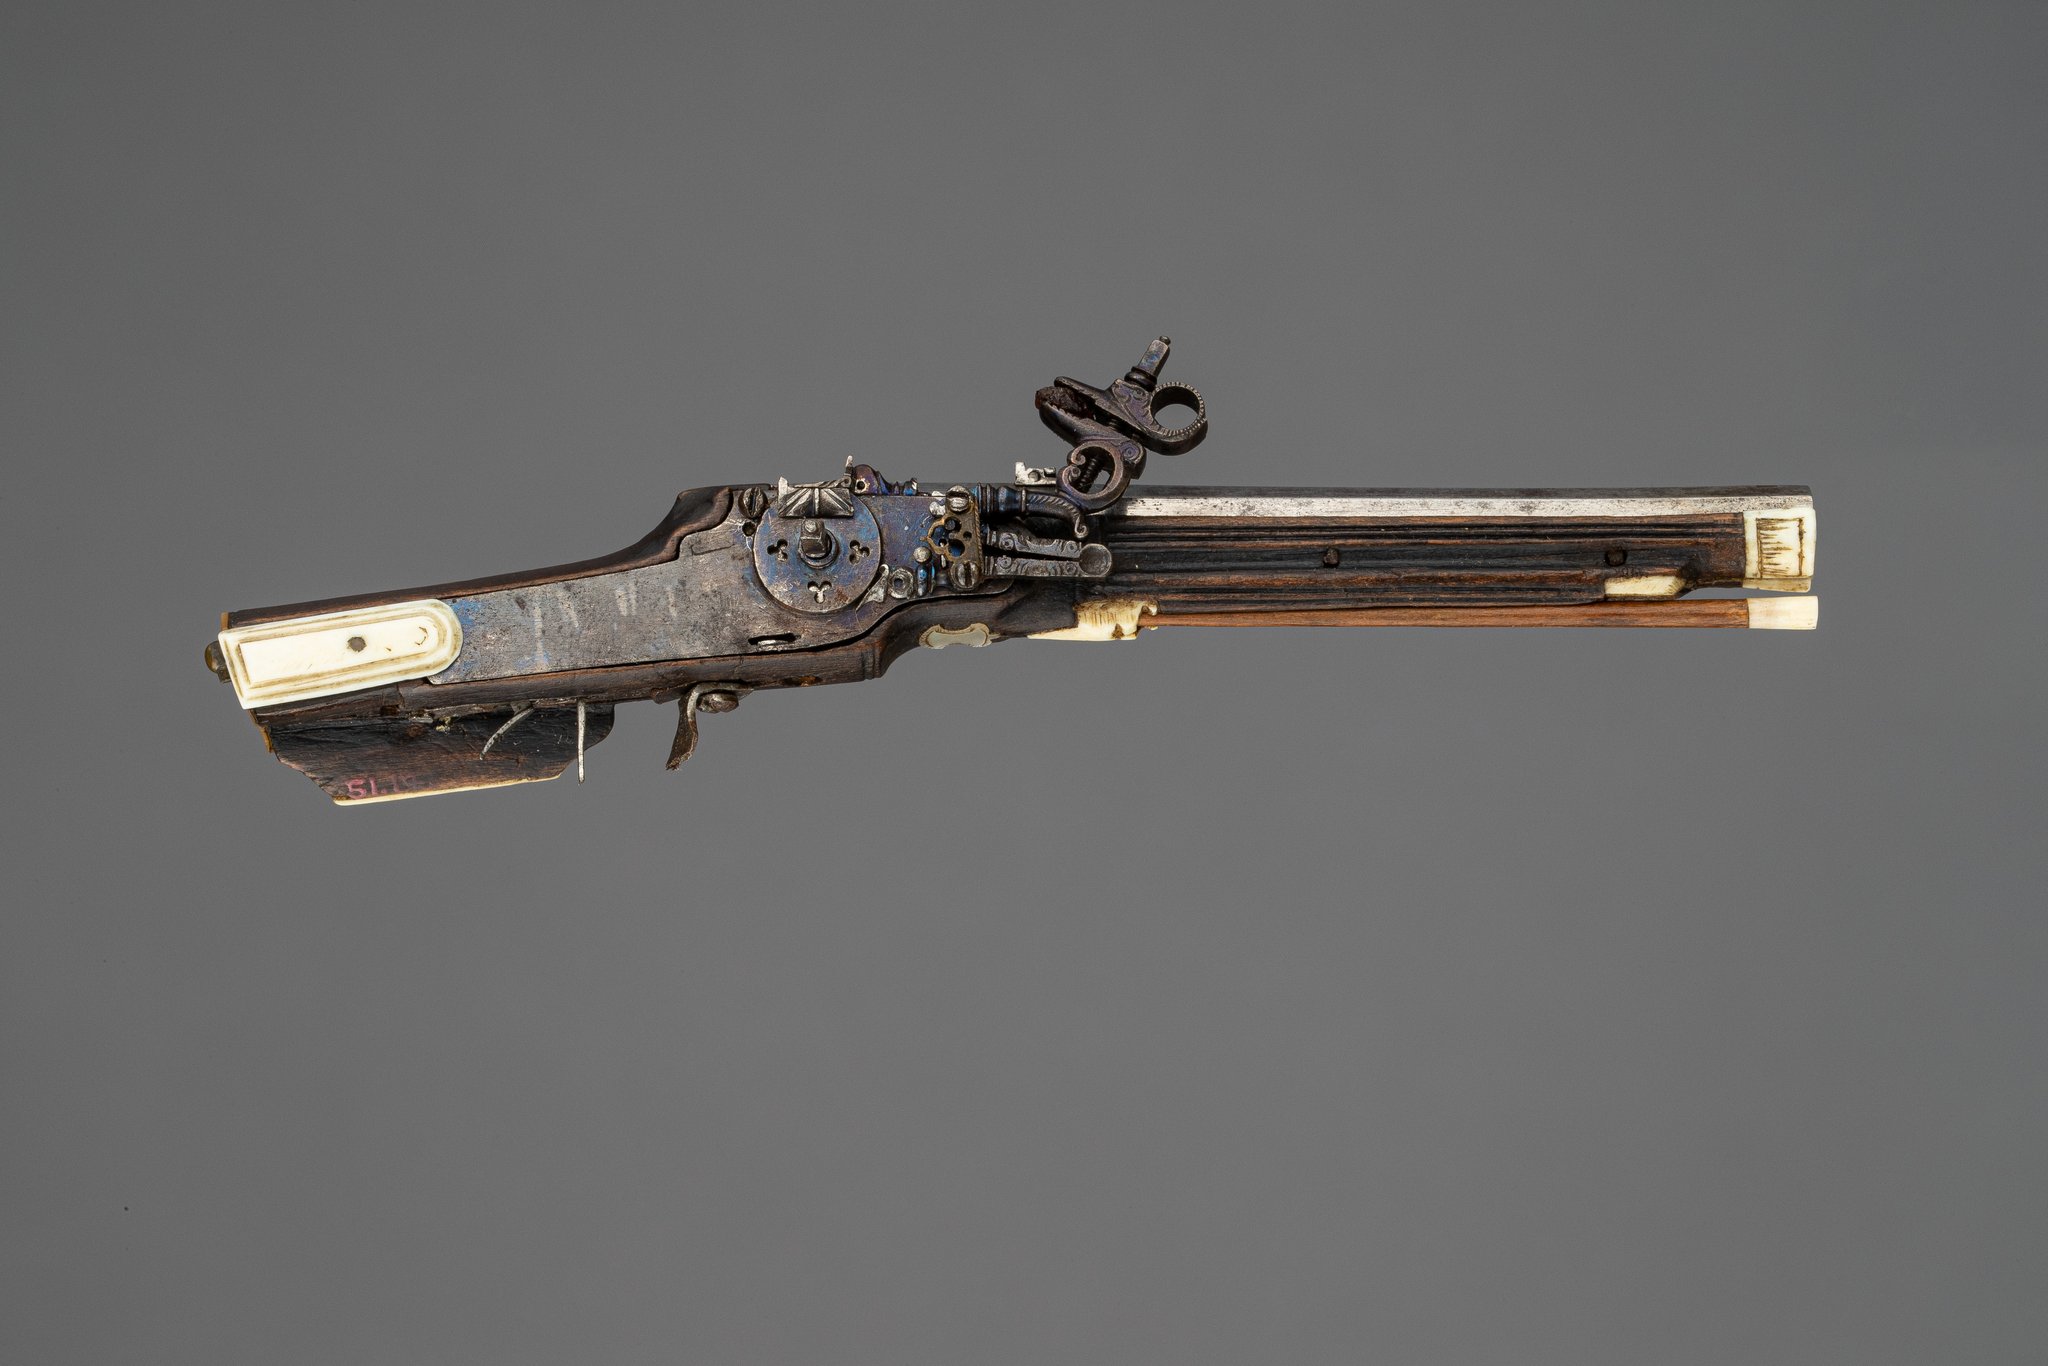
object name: model of wheellock rifle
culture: german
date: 1700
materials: ivory, mother of pearl, silver, steel, wood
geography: germany